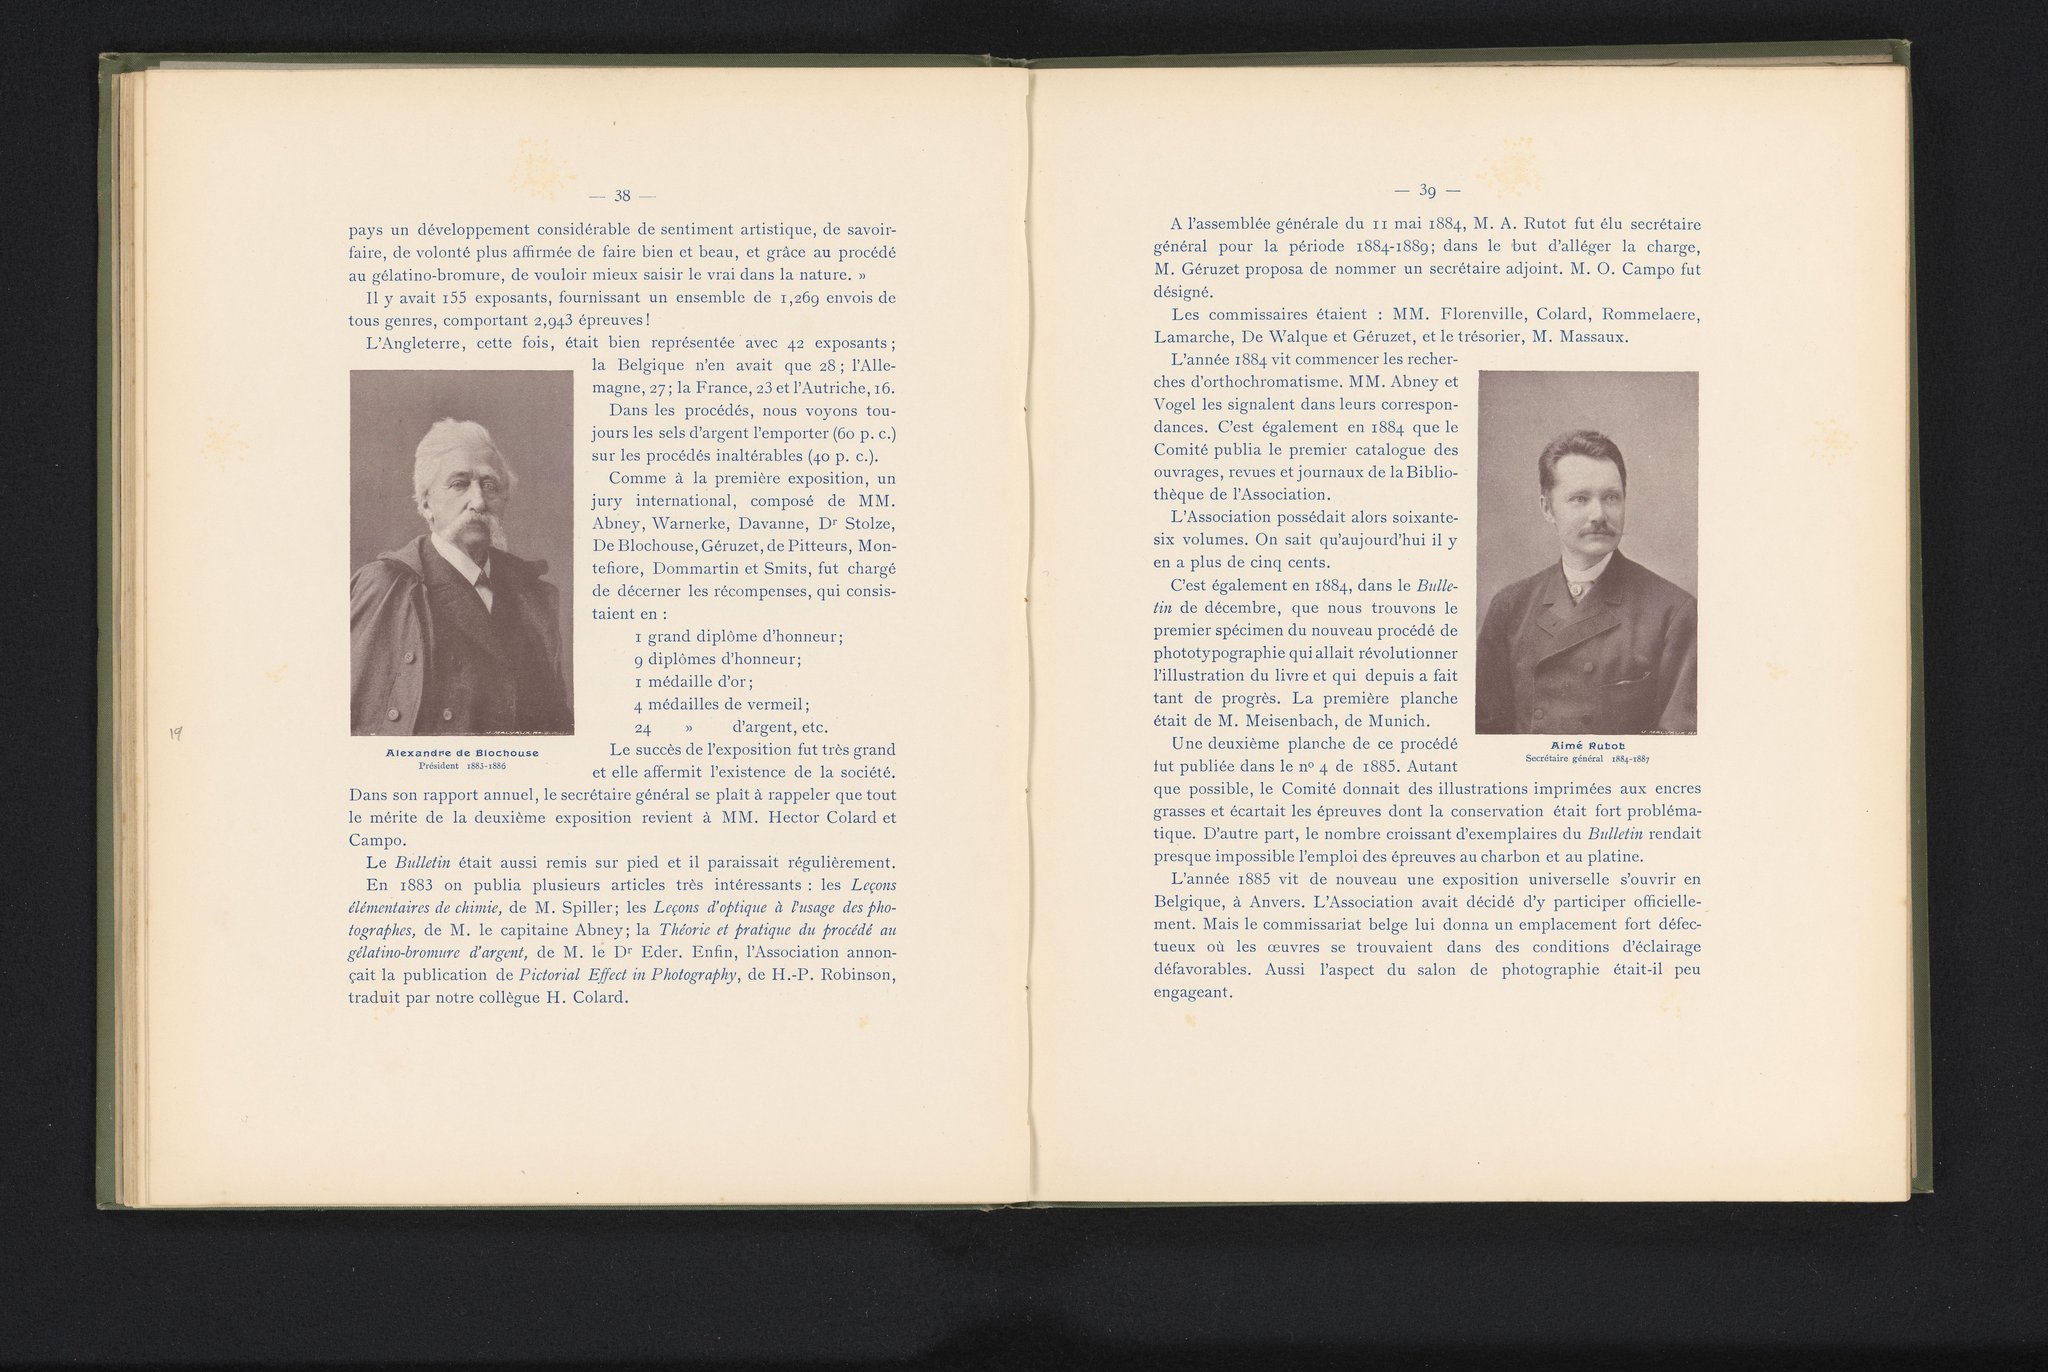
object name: page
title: Aimé Rutot, Secrétaire général 1884-1887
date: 1893-1898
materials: paper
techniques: autotype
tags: brussels, engineer, aimé louis rutot, historical persons